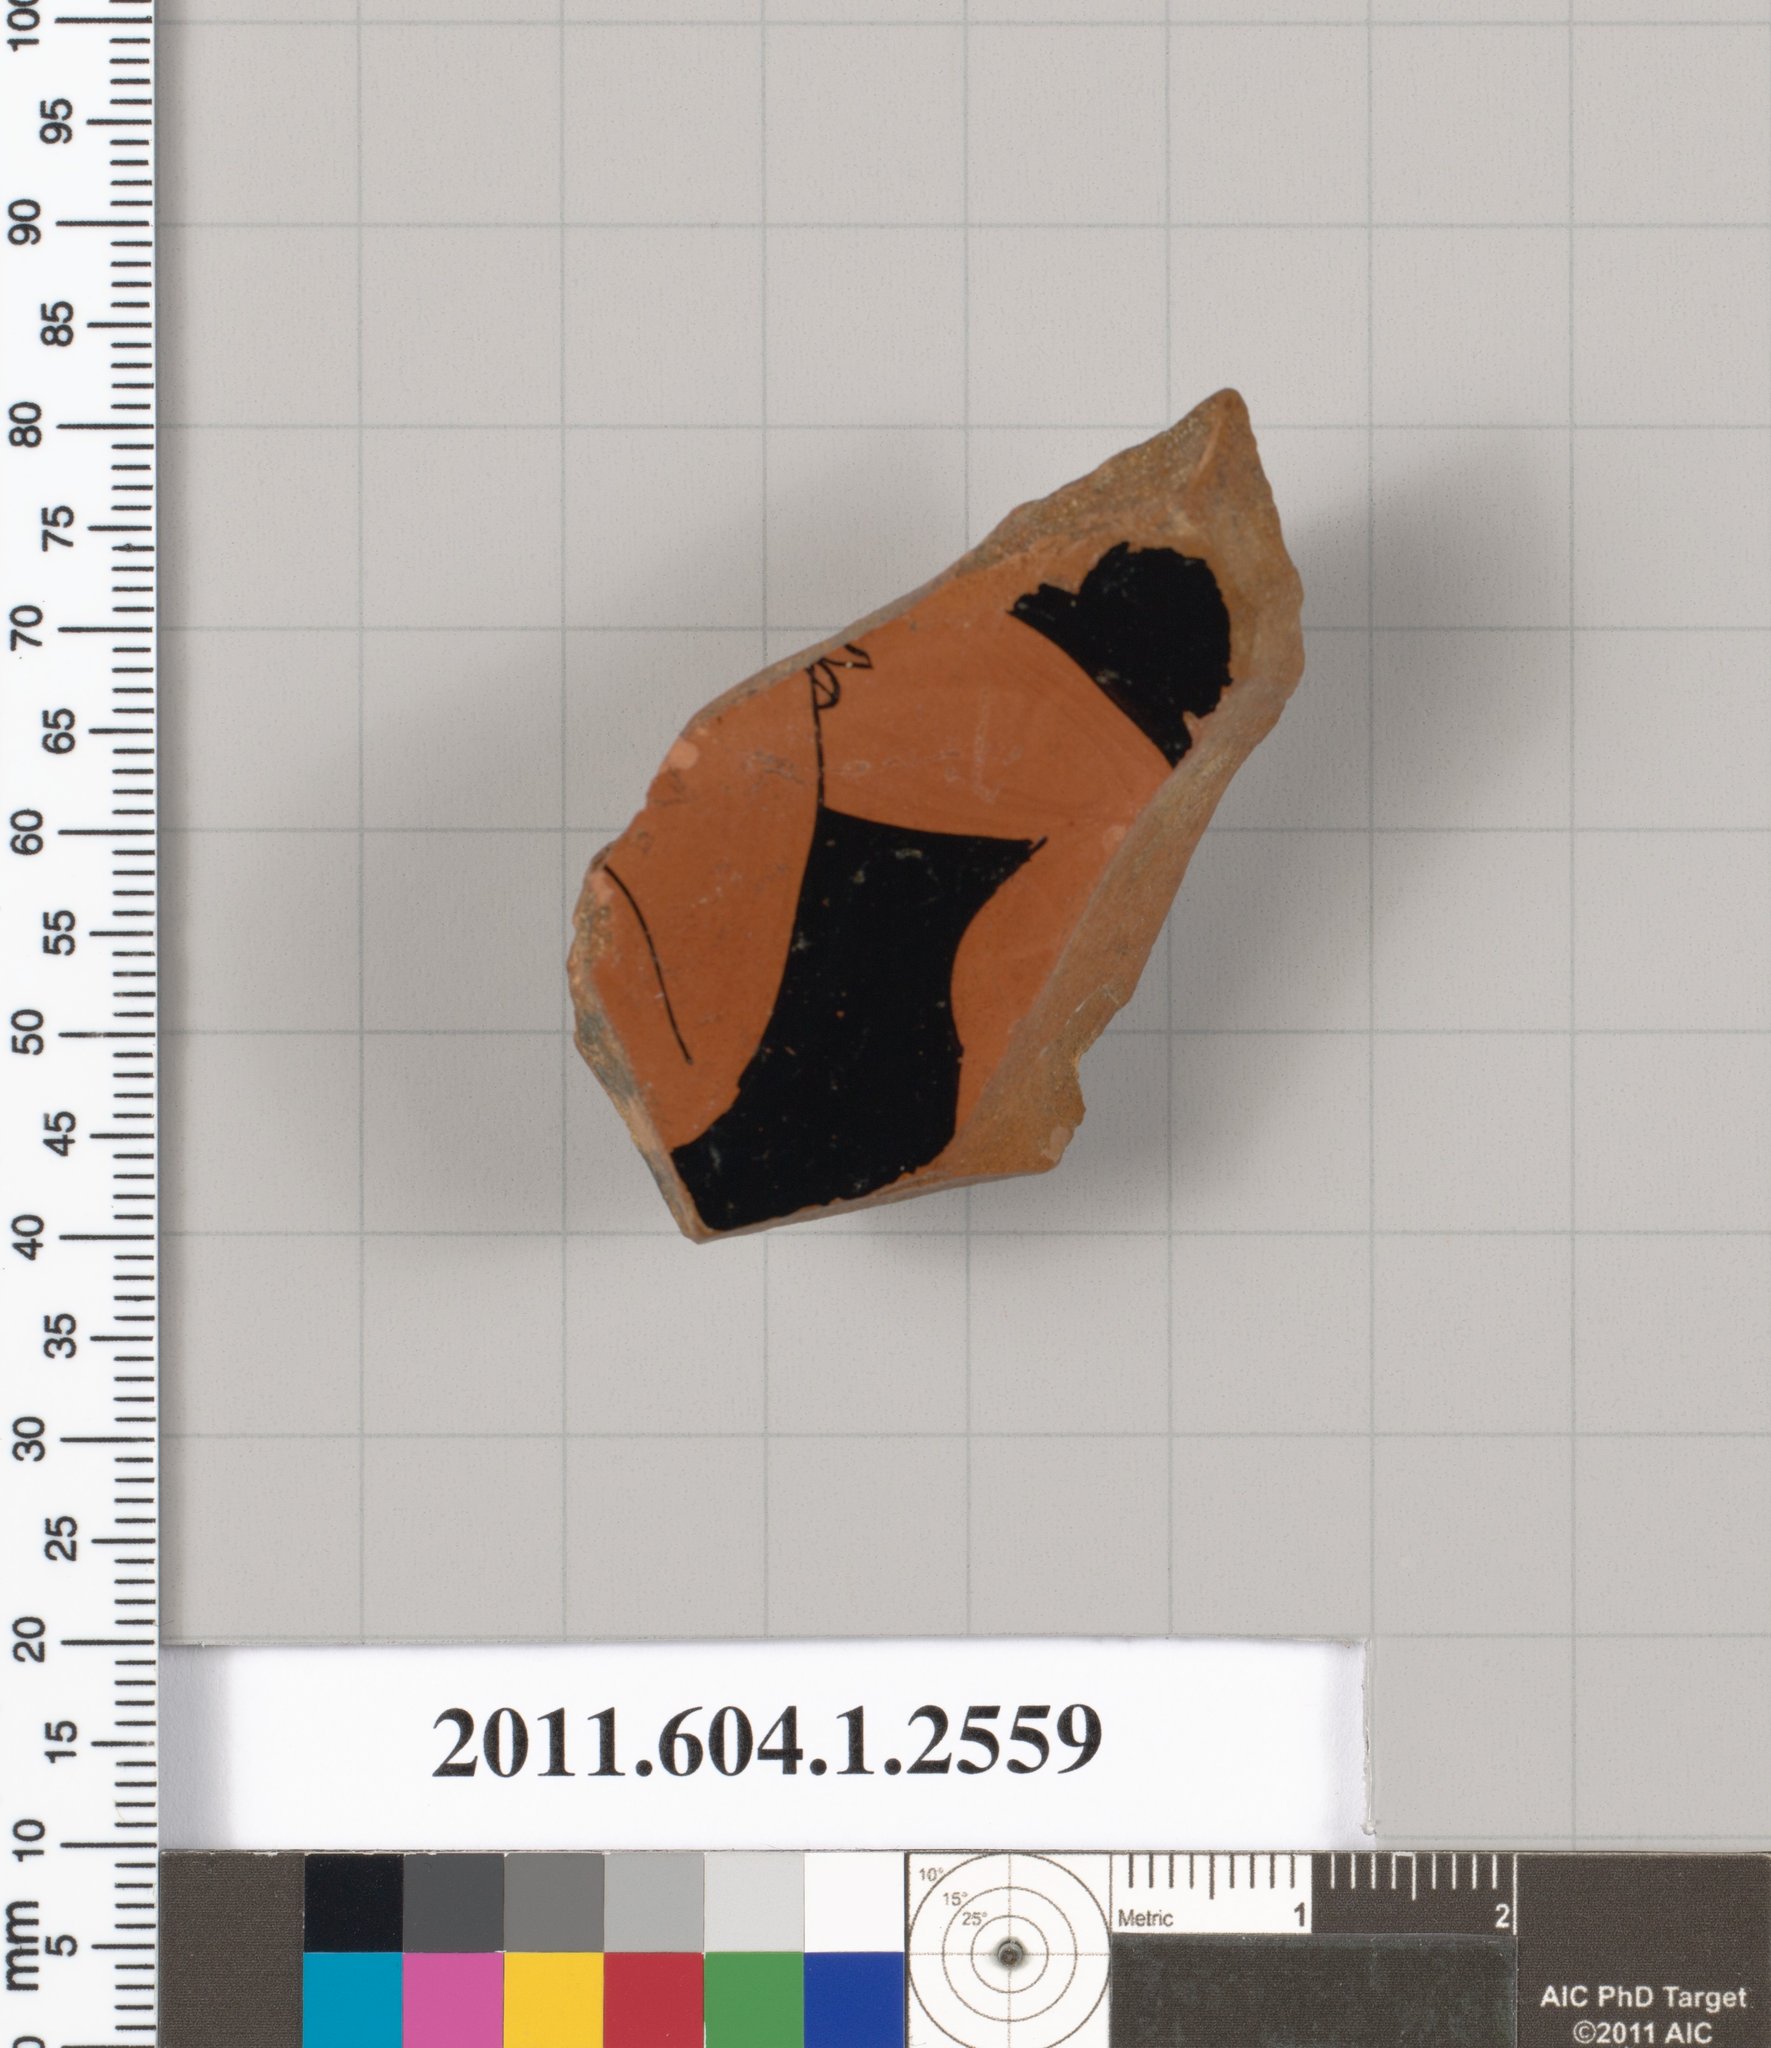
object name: kylix fragment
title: Terracotta fragment of a kylix (drinking cup)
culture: greek, attic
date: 490-480 BCE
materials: terracotta